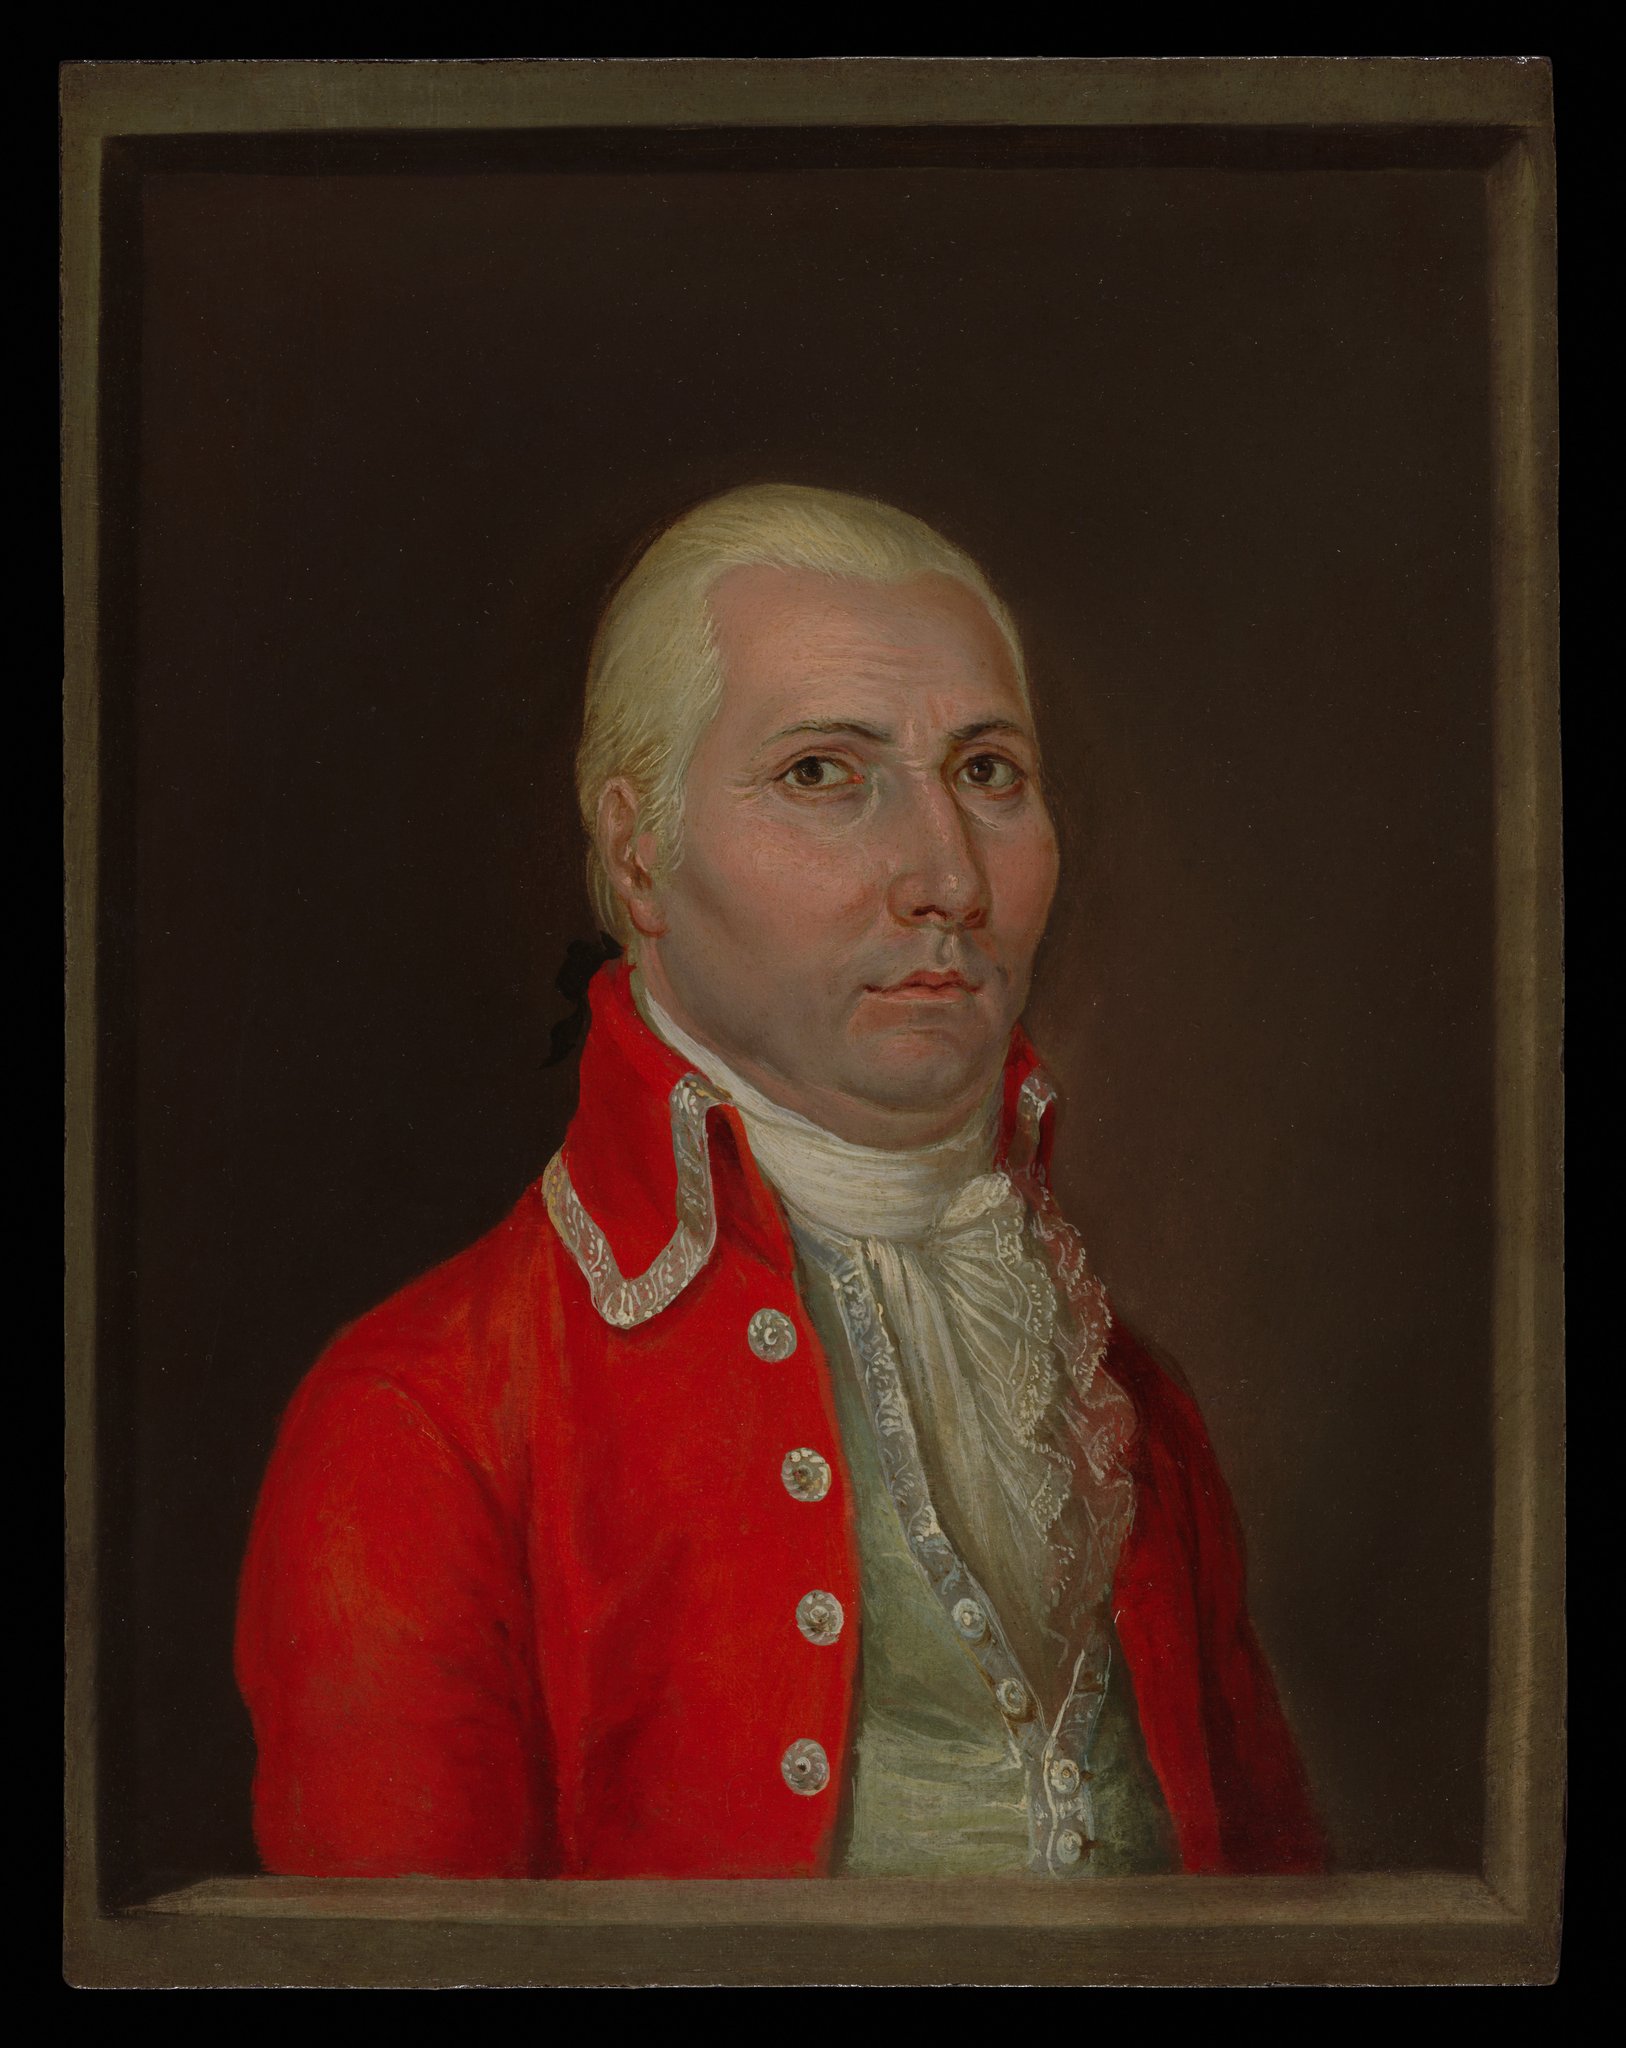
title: Portrait of Nicolás Matías Fernández Méndez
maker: josé campeche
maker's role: artist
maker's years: 1751-1809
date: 1800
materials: oil, panel, wood